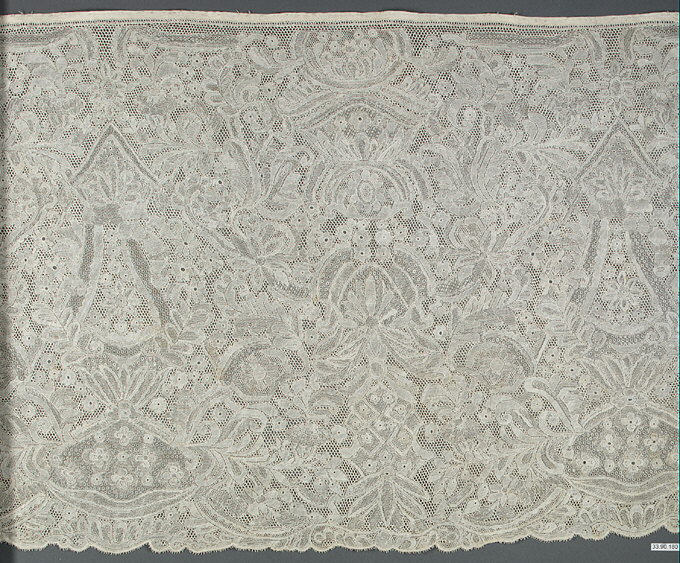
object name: flounce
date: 1701-1800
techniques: embroidery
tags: flowers